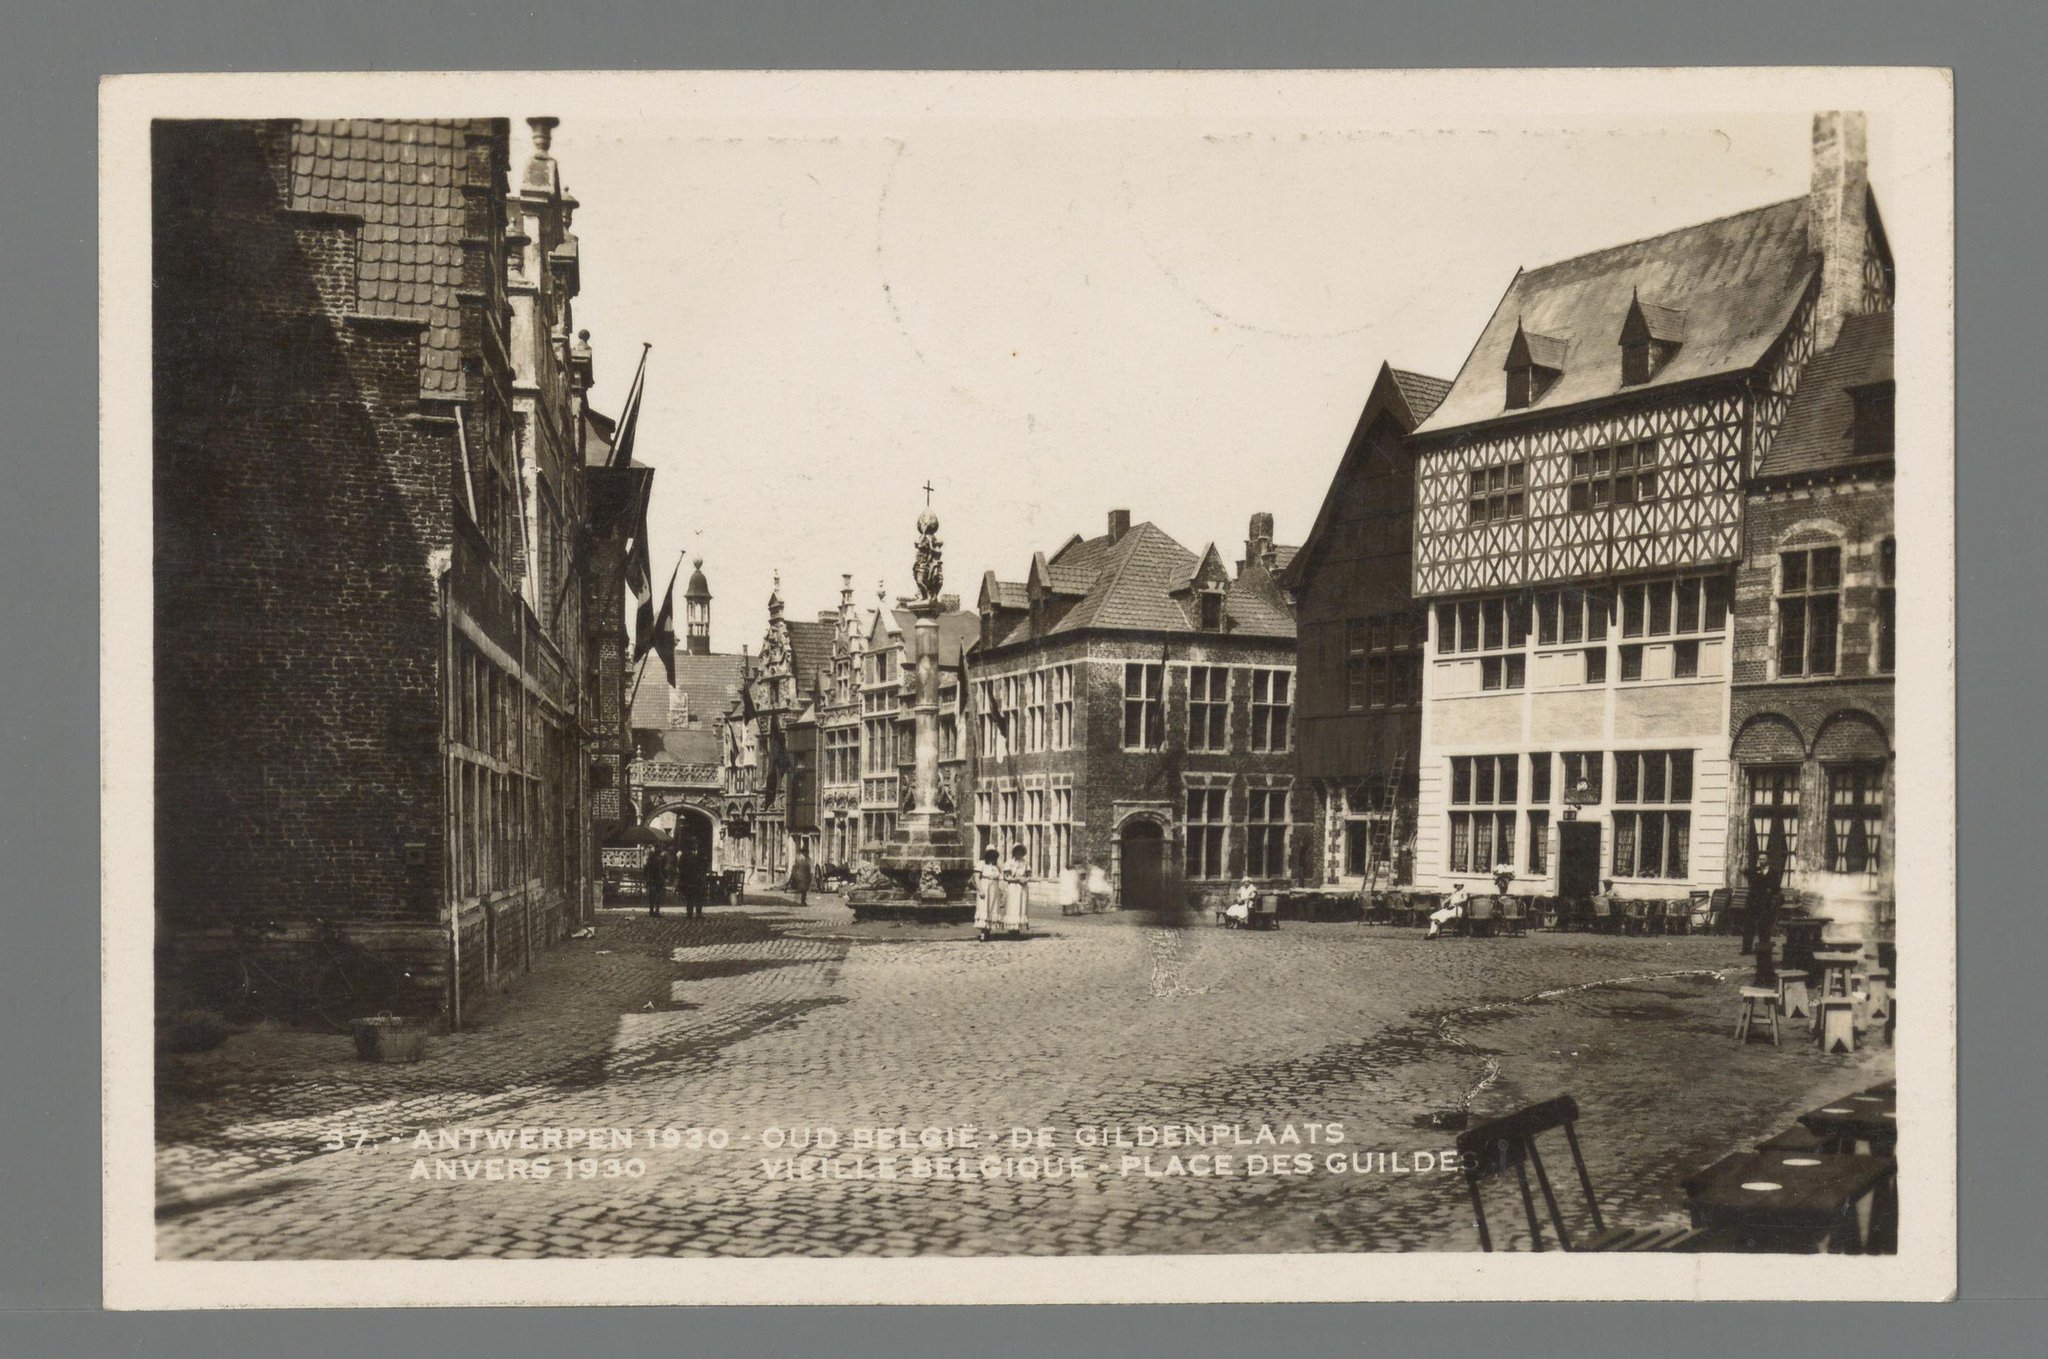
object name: ansichtkaart, prentbriefkaart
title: Oud België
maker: Anonymous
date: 1930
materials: photographic support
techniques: photography, writing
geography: antwerp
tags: square, place, circus, etc., urban housing, street, antwerp